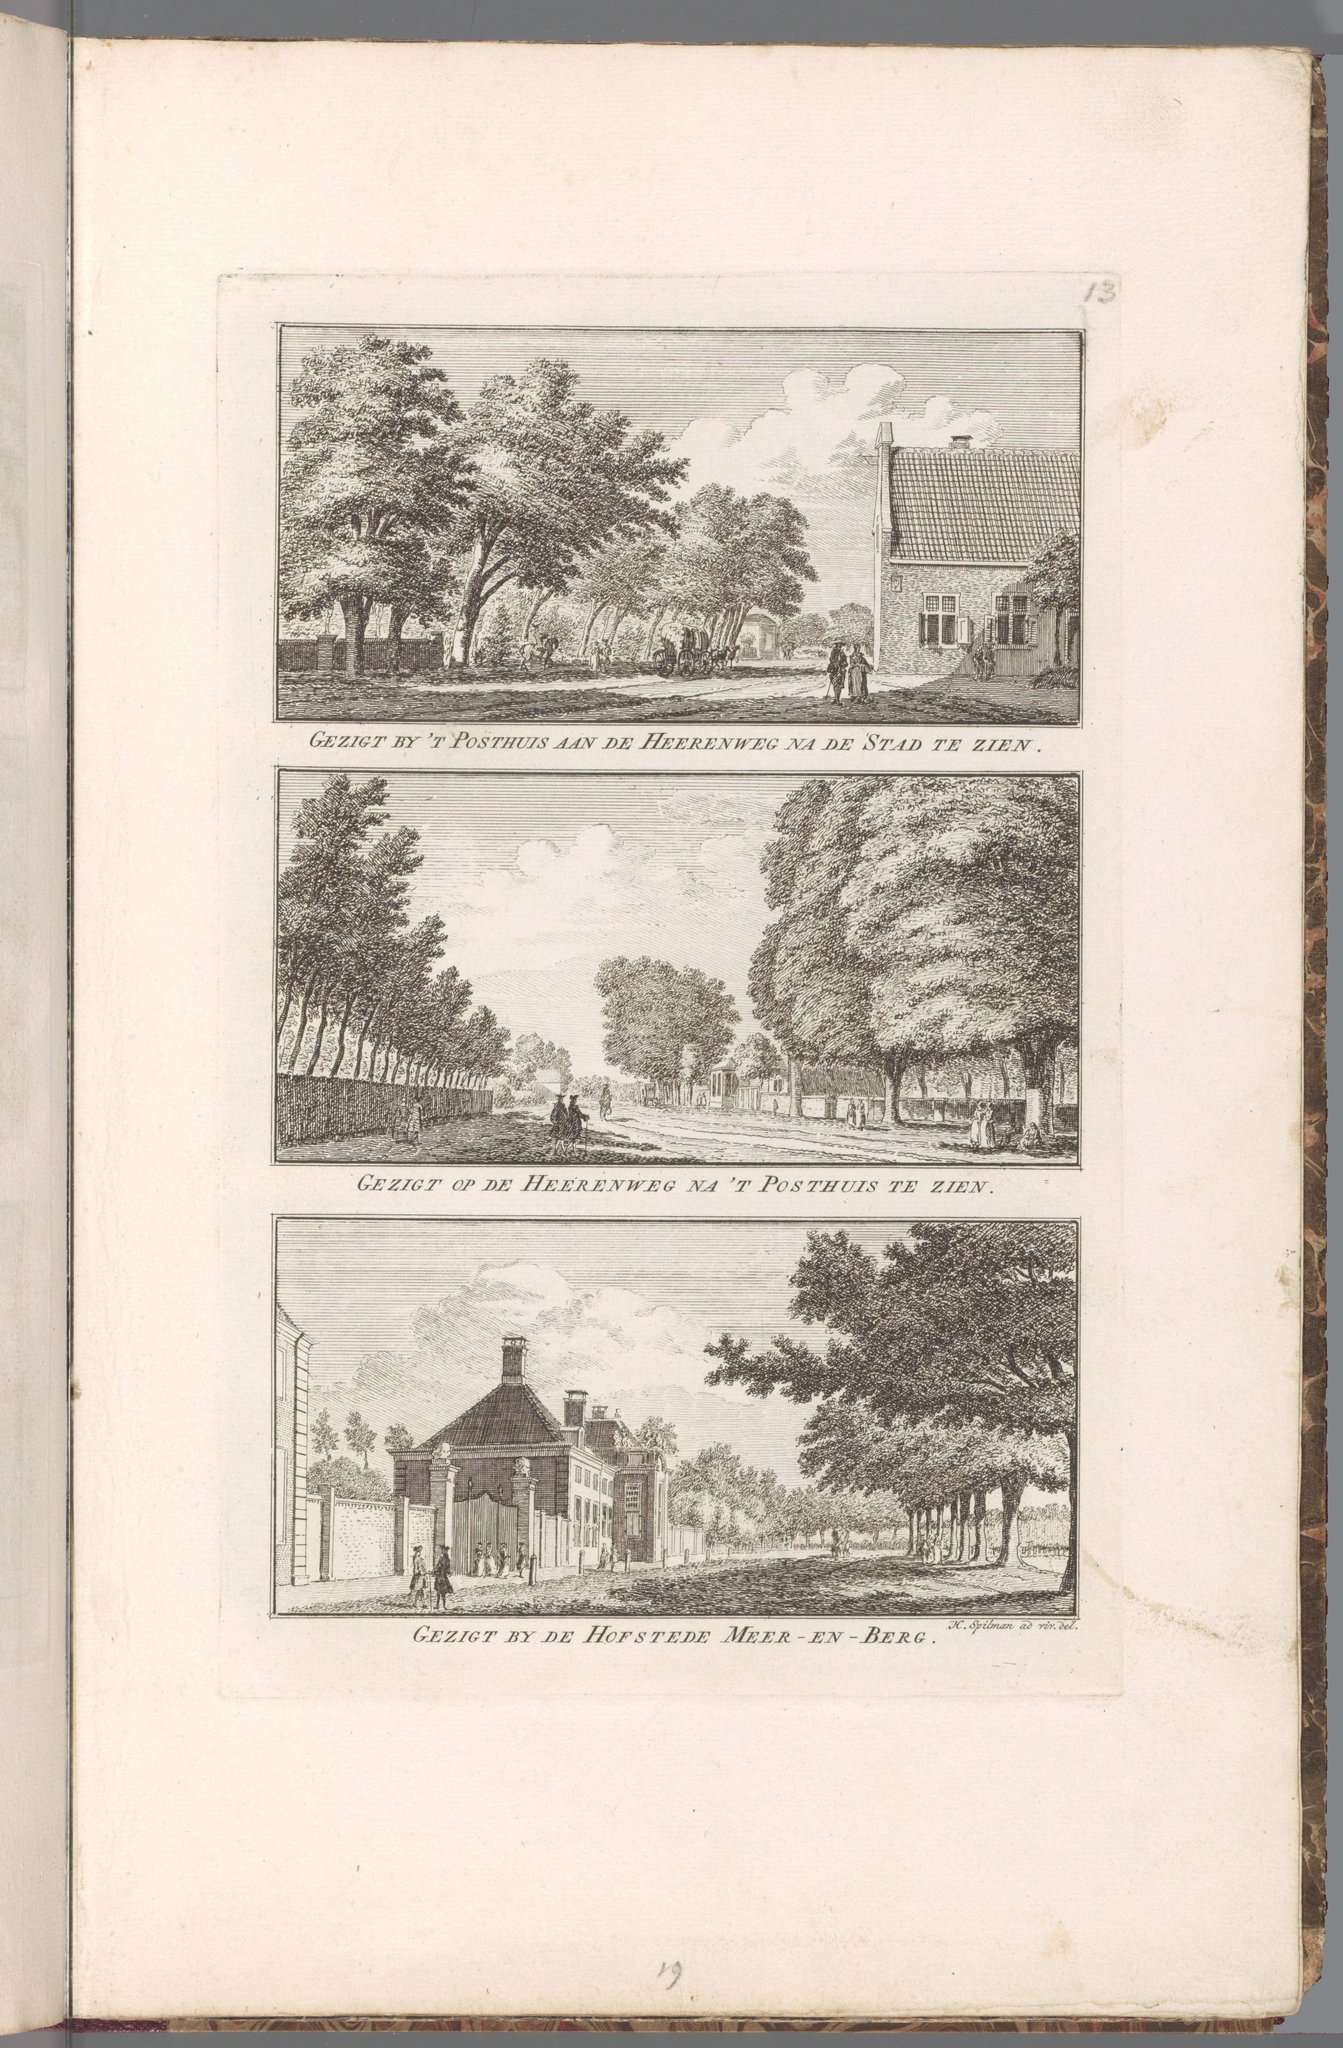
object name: print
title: Gezigt by 't Posthuis aan de Heerenweg na de Stad te zien / Gezigt op de Heerenweg na 't Posthuis te zien / Gezigt by de Hofstede Meer-en-Berg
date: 1762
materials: paper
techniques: etching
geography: haarlem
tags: rural housing, e.g. country-house, villa, cottage, lane, alley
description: Drie voorstellingen. Boven: Het posthuis aan de Herenweg in Heemstede. Midden: De Herenweg bij het posthuis te Heemstede. Onder: Gezicht op de hofstede Meer en Berg te Heemstede. Deze prent maakt deel uit van een album.